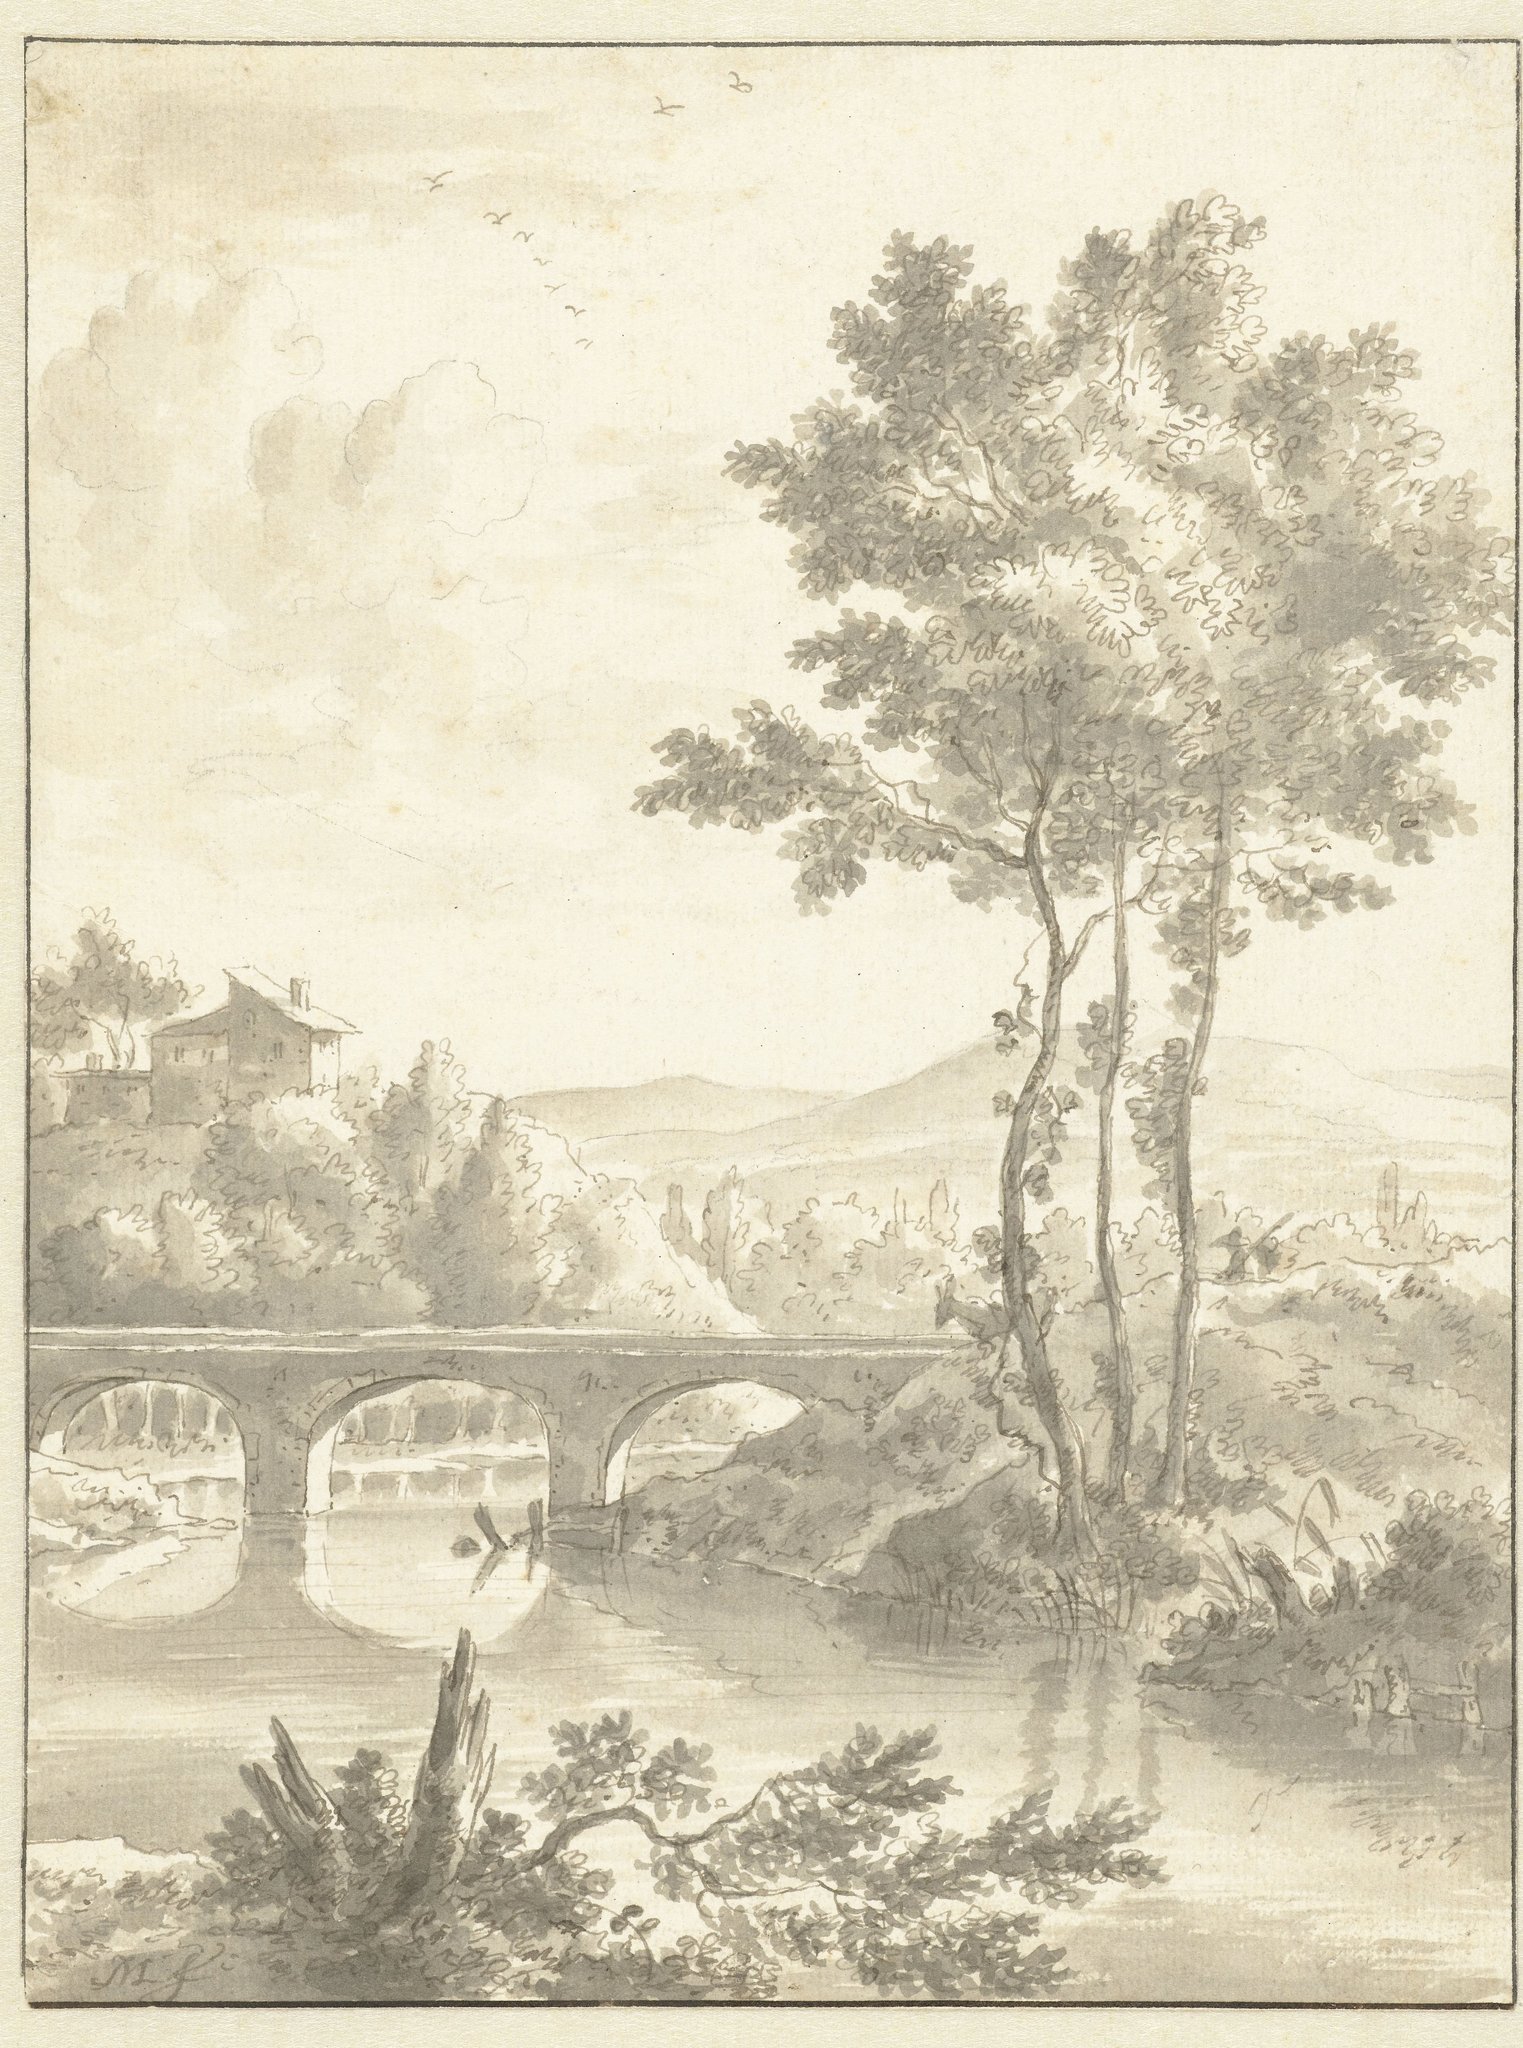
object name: drawing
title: Landscape with a Multi-Arched Bridge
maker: frederik de moucheron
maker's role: draughtsman, painter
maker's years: 1633-1686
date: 1660-1680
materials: graphite, ink, paper, pencil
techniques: brush, pen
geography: amsterdam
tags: landscape with bridge, viaduct or aqueduct